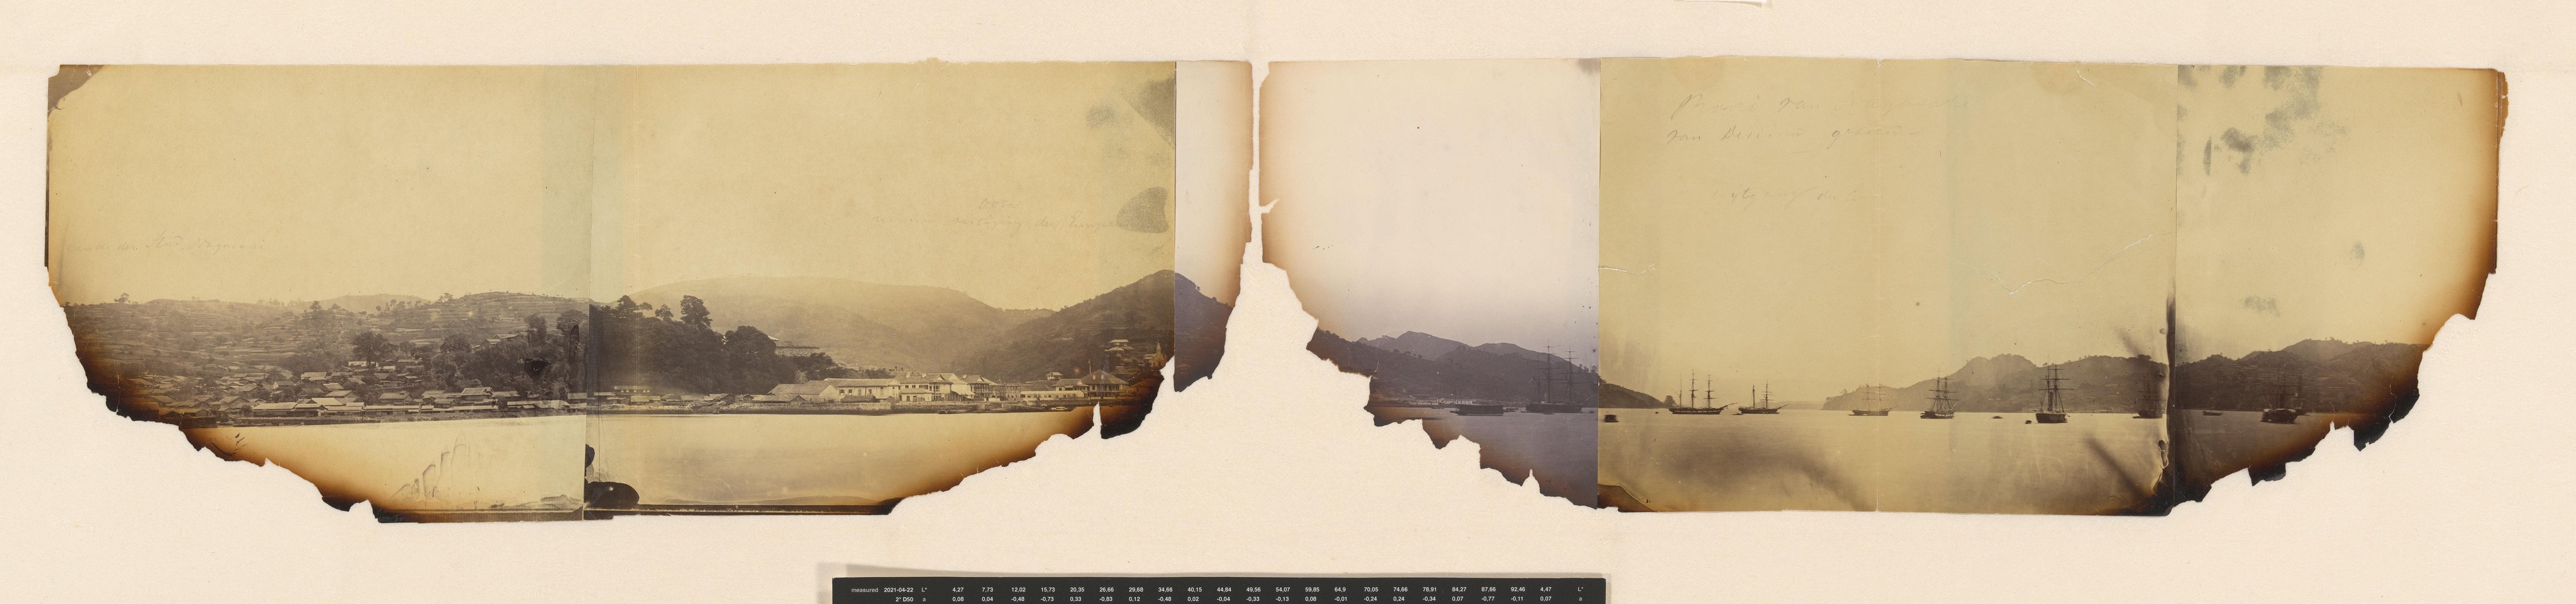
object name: photograph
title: View of Nagasaki Bay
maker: antoon bauduin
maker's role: amateurfotograaf, hoogleraar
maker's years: 1820-1885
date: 1862-1866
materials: paper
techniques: albumen print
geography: japan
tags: nagasaki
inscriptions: verso, potlood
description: This panoramic view of Nagasaki consists of six separate shots. Bauduin is thought to have taken them, and it corresponds to the view from his house on Dejima. In it, the bay appears much wider than it really was. This is an optical deformation arising from taking six shots from the same position.